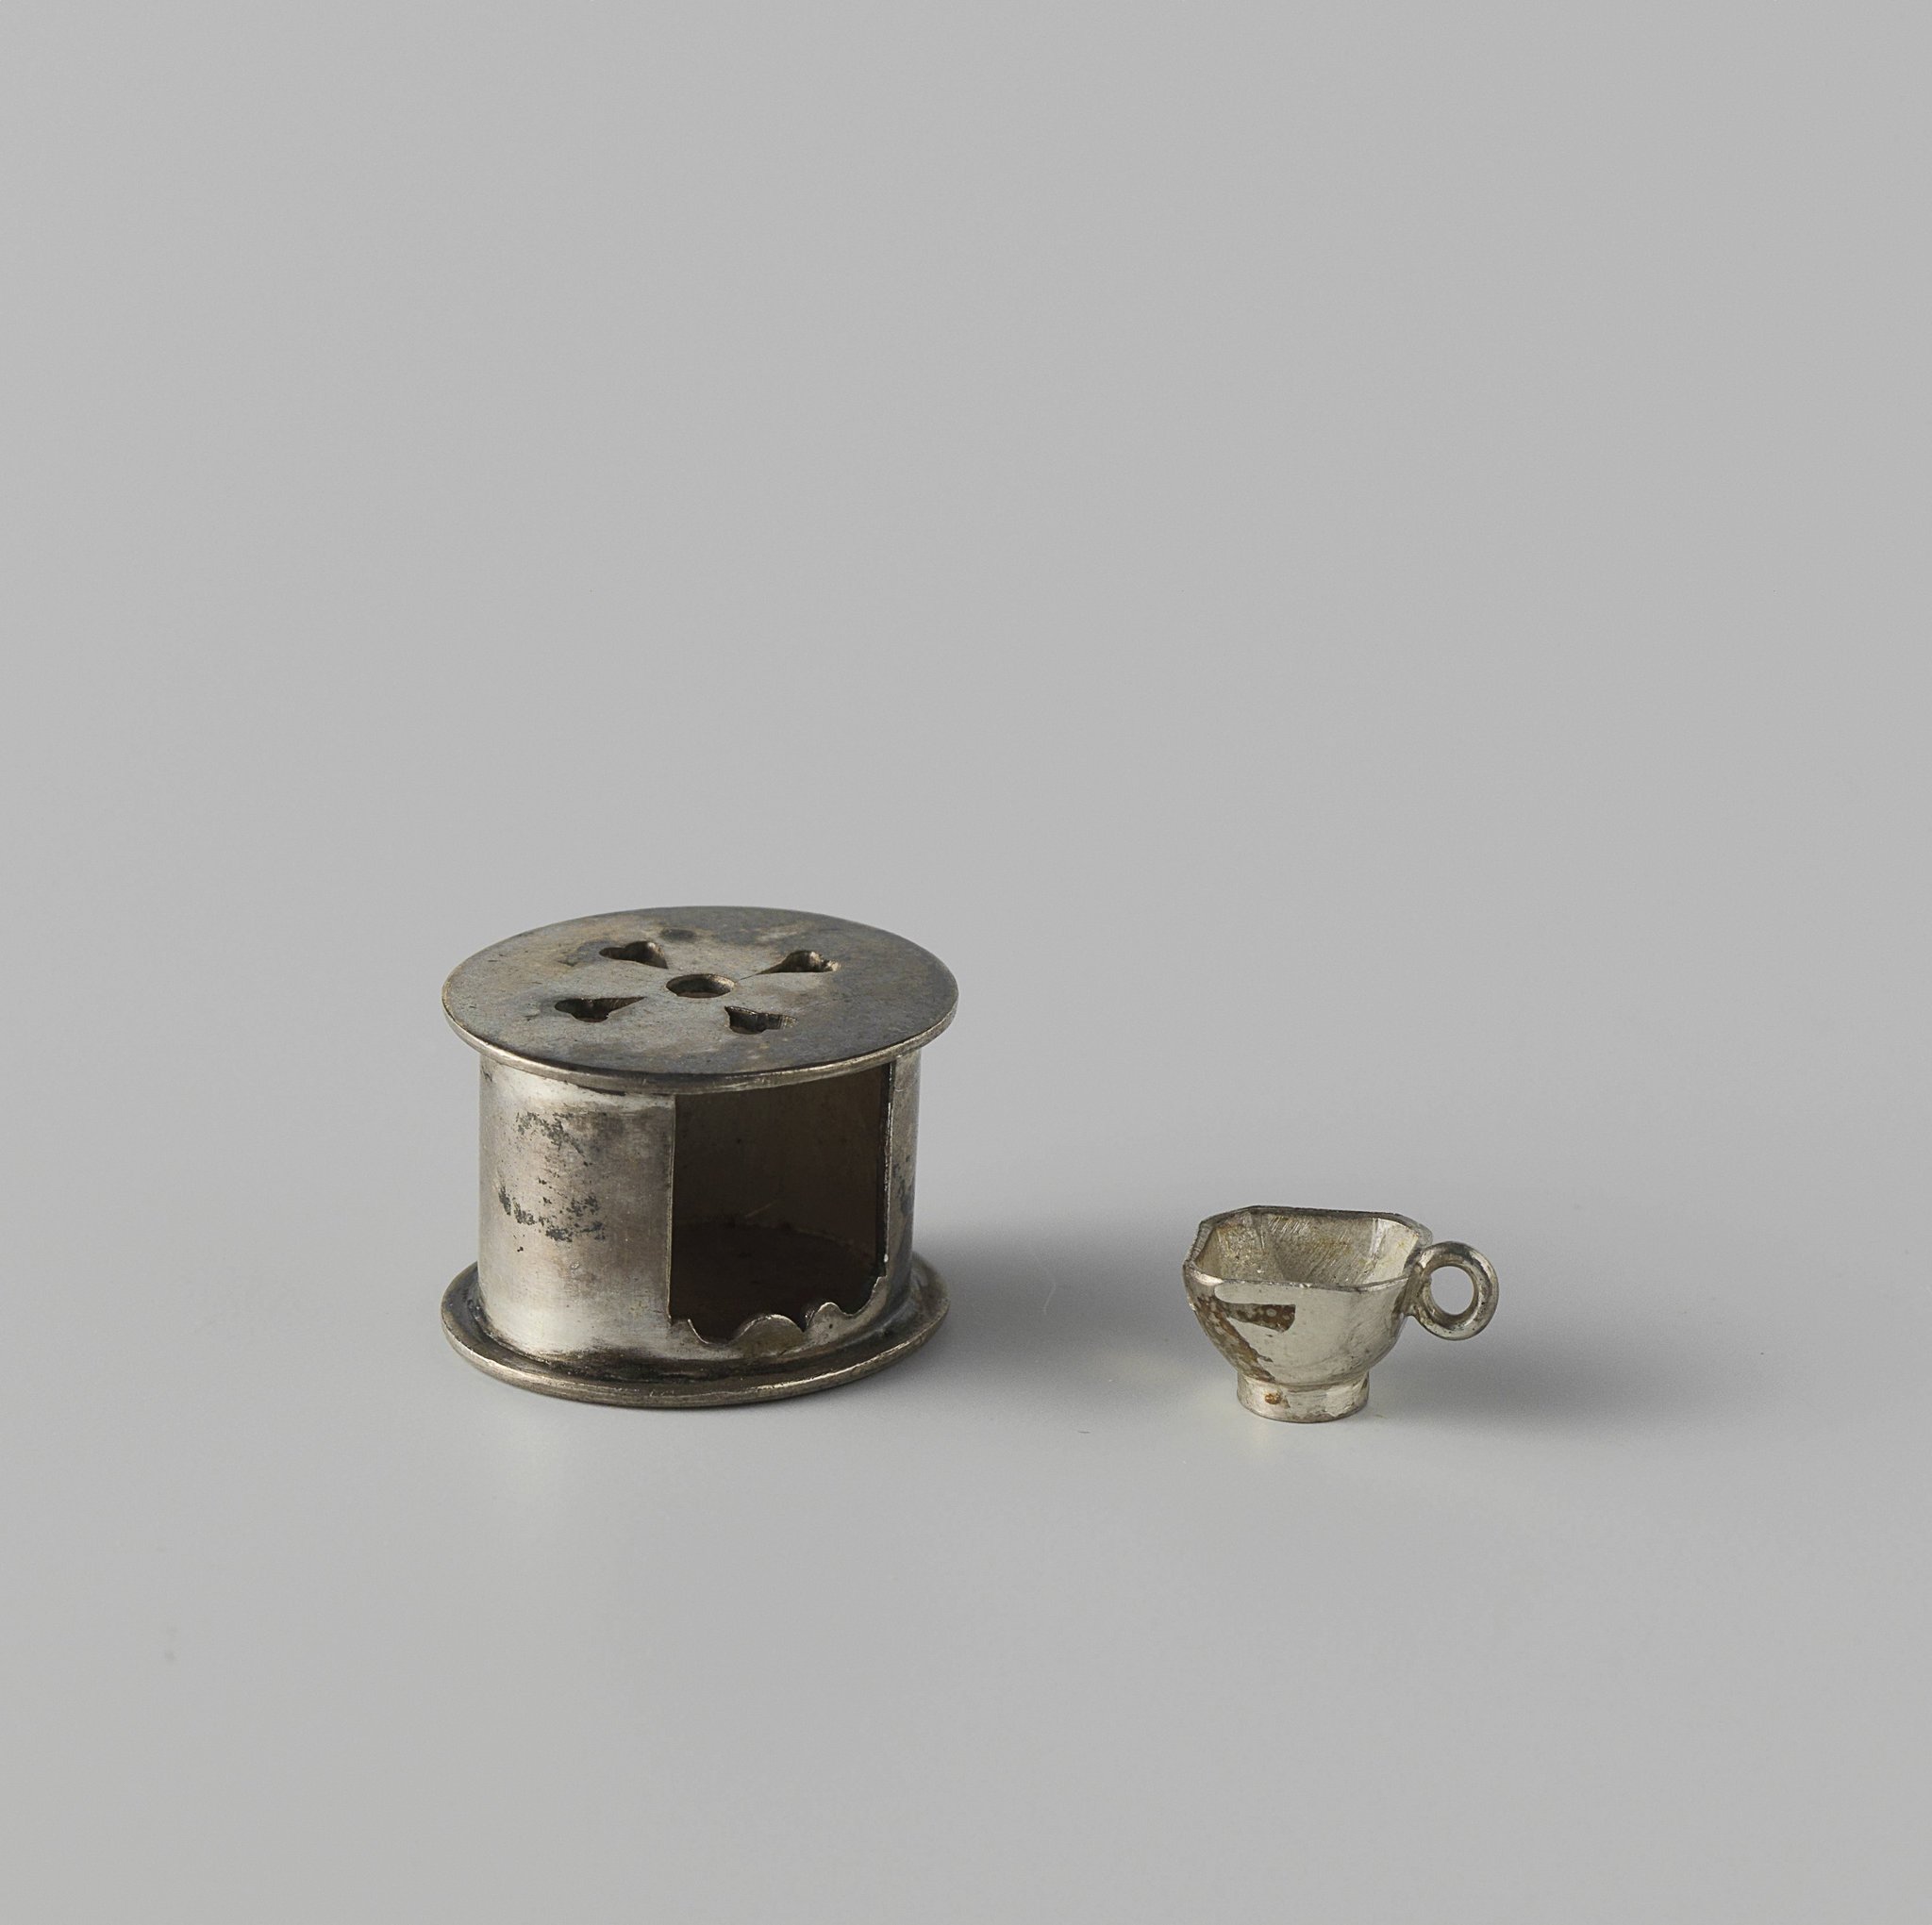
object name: miniature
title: Stoof met uitgezaagde harten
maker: Anonymous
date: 1755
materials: silver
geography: amsterdam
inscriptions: maker's mark: ‘voet 430’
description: Ovale stoof met test. In de bovenkant van de stoof is in het midden een rond gat uitgezaagd en daar omheen vier opengezaagde harten. In de stoof staat een test op een voet en met een oor. De stoof is gemerkt: mt.= Voet 430. De stoof is gelijk aan vijf stoven met de invnrs. BK-NM-11177-175, BK-NM-11177-176, BK-NM-11177-177, BK-NM-11177-179, BK-NM-11177-180.